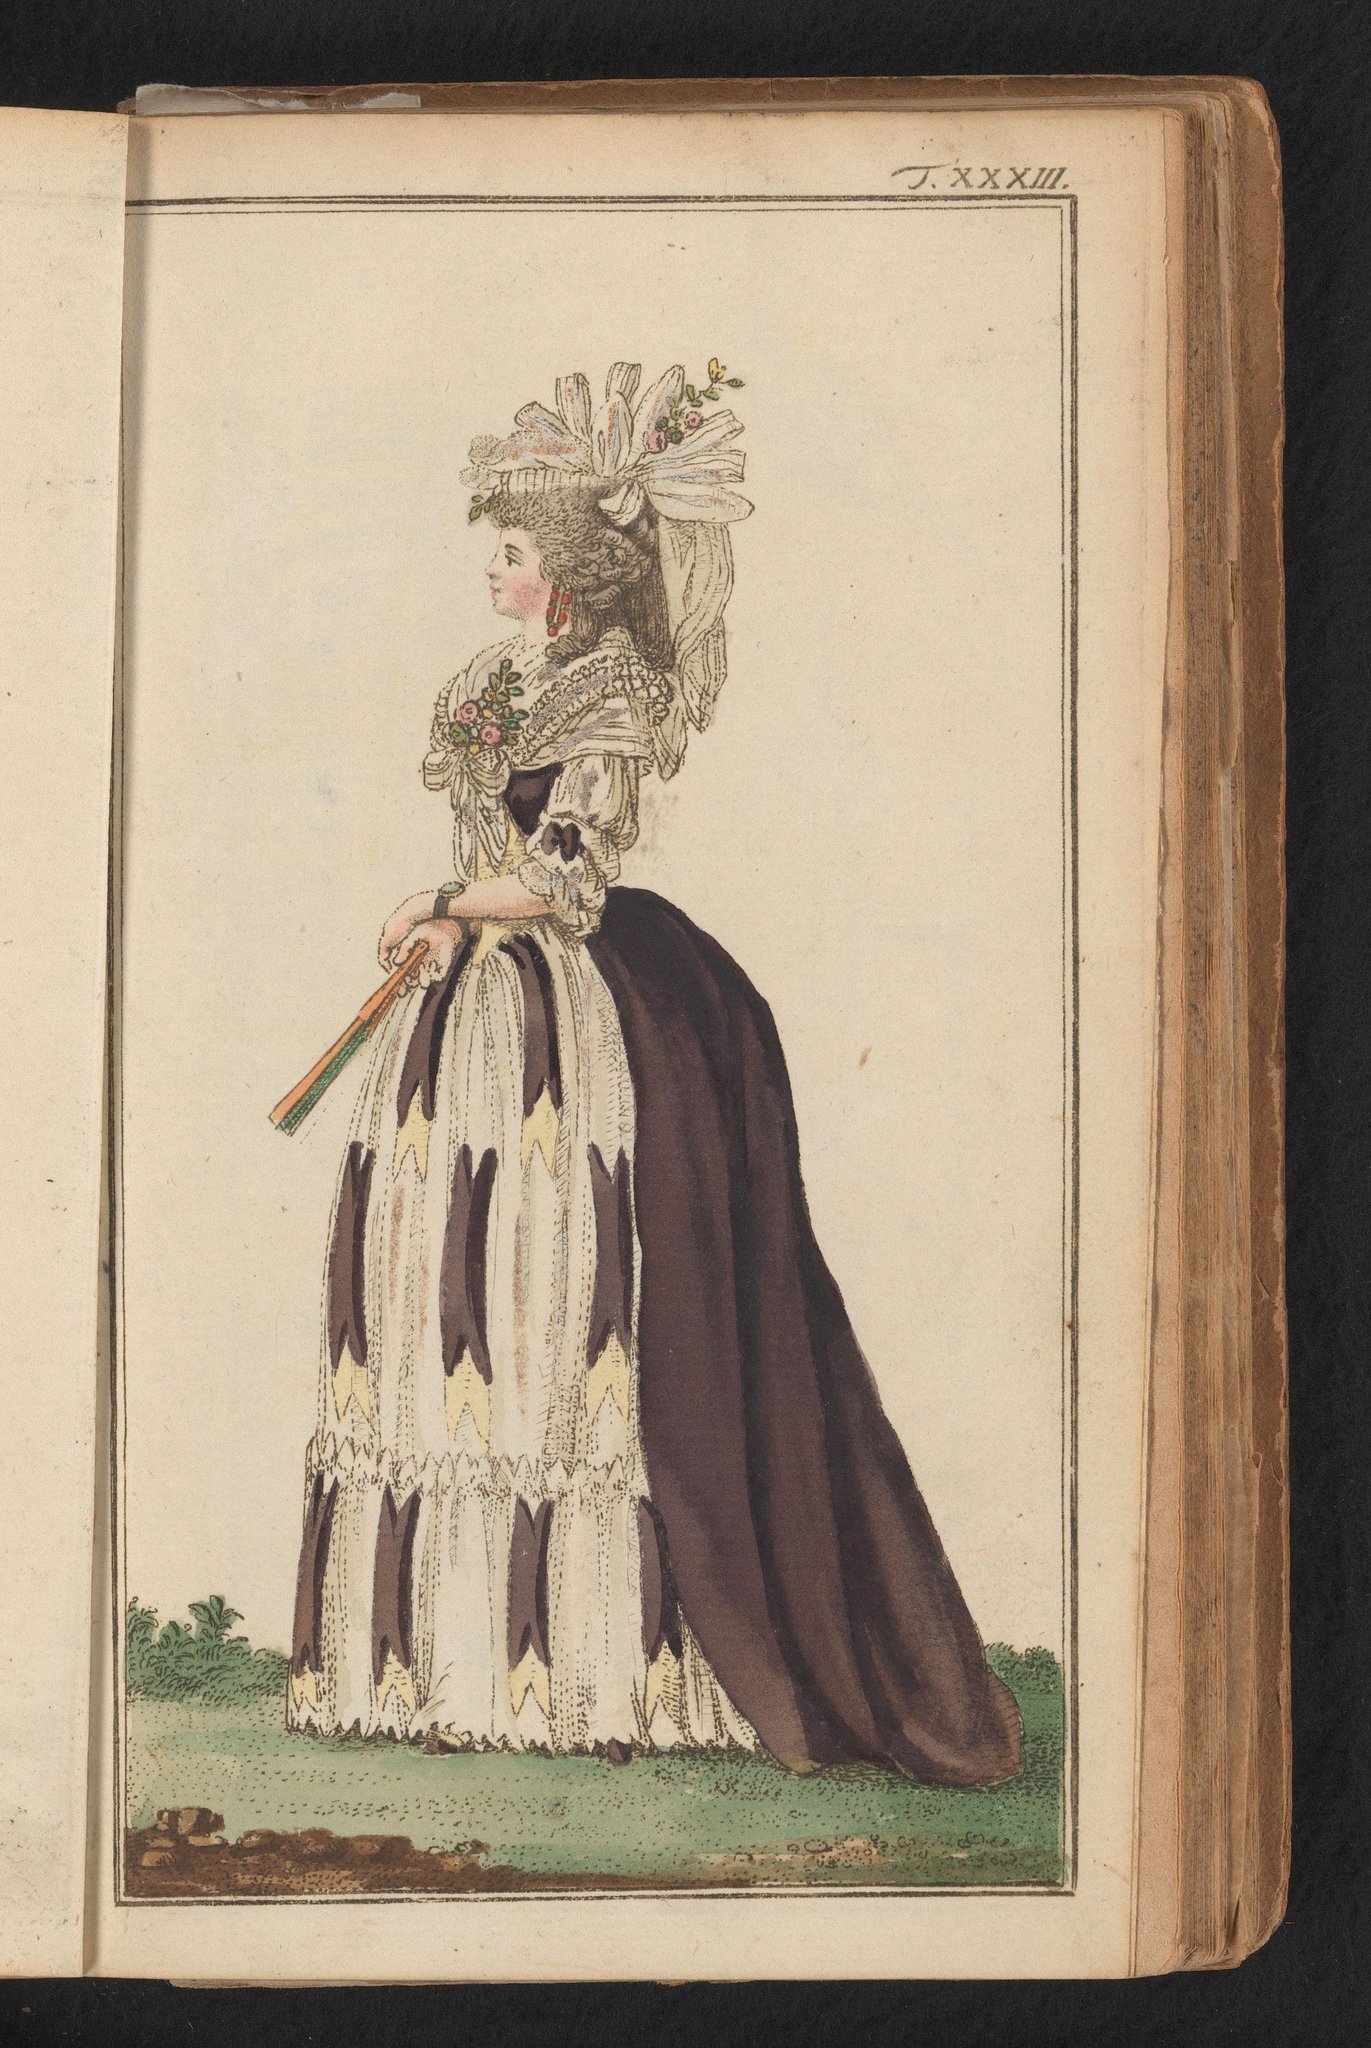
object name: fashion print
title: Journal des Luxus und der Moden 1786, Band I, T. 33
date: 1786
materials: paper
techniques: etching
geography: weimar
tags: fashion plates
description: Vrouw naar links, in een Robe à la Turque, van violette Peking (?) met mouwen van krip. Lijfje en rok van lichtgele Peking. Over de gele rok een witte rok met brede falbala en met geel met paarse stukken band belegd. Prent uit het modetijdschrift Journal des Luxus und der Moden, uitgegeven door Friedrich Justin Bertuch en Georg Melchior Kraus, Weimar, 1786-1826.